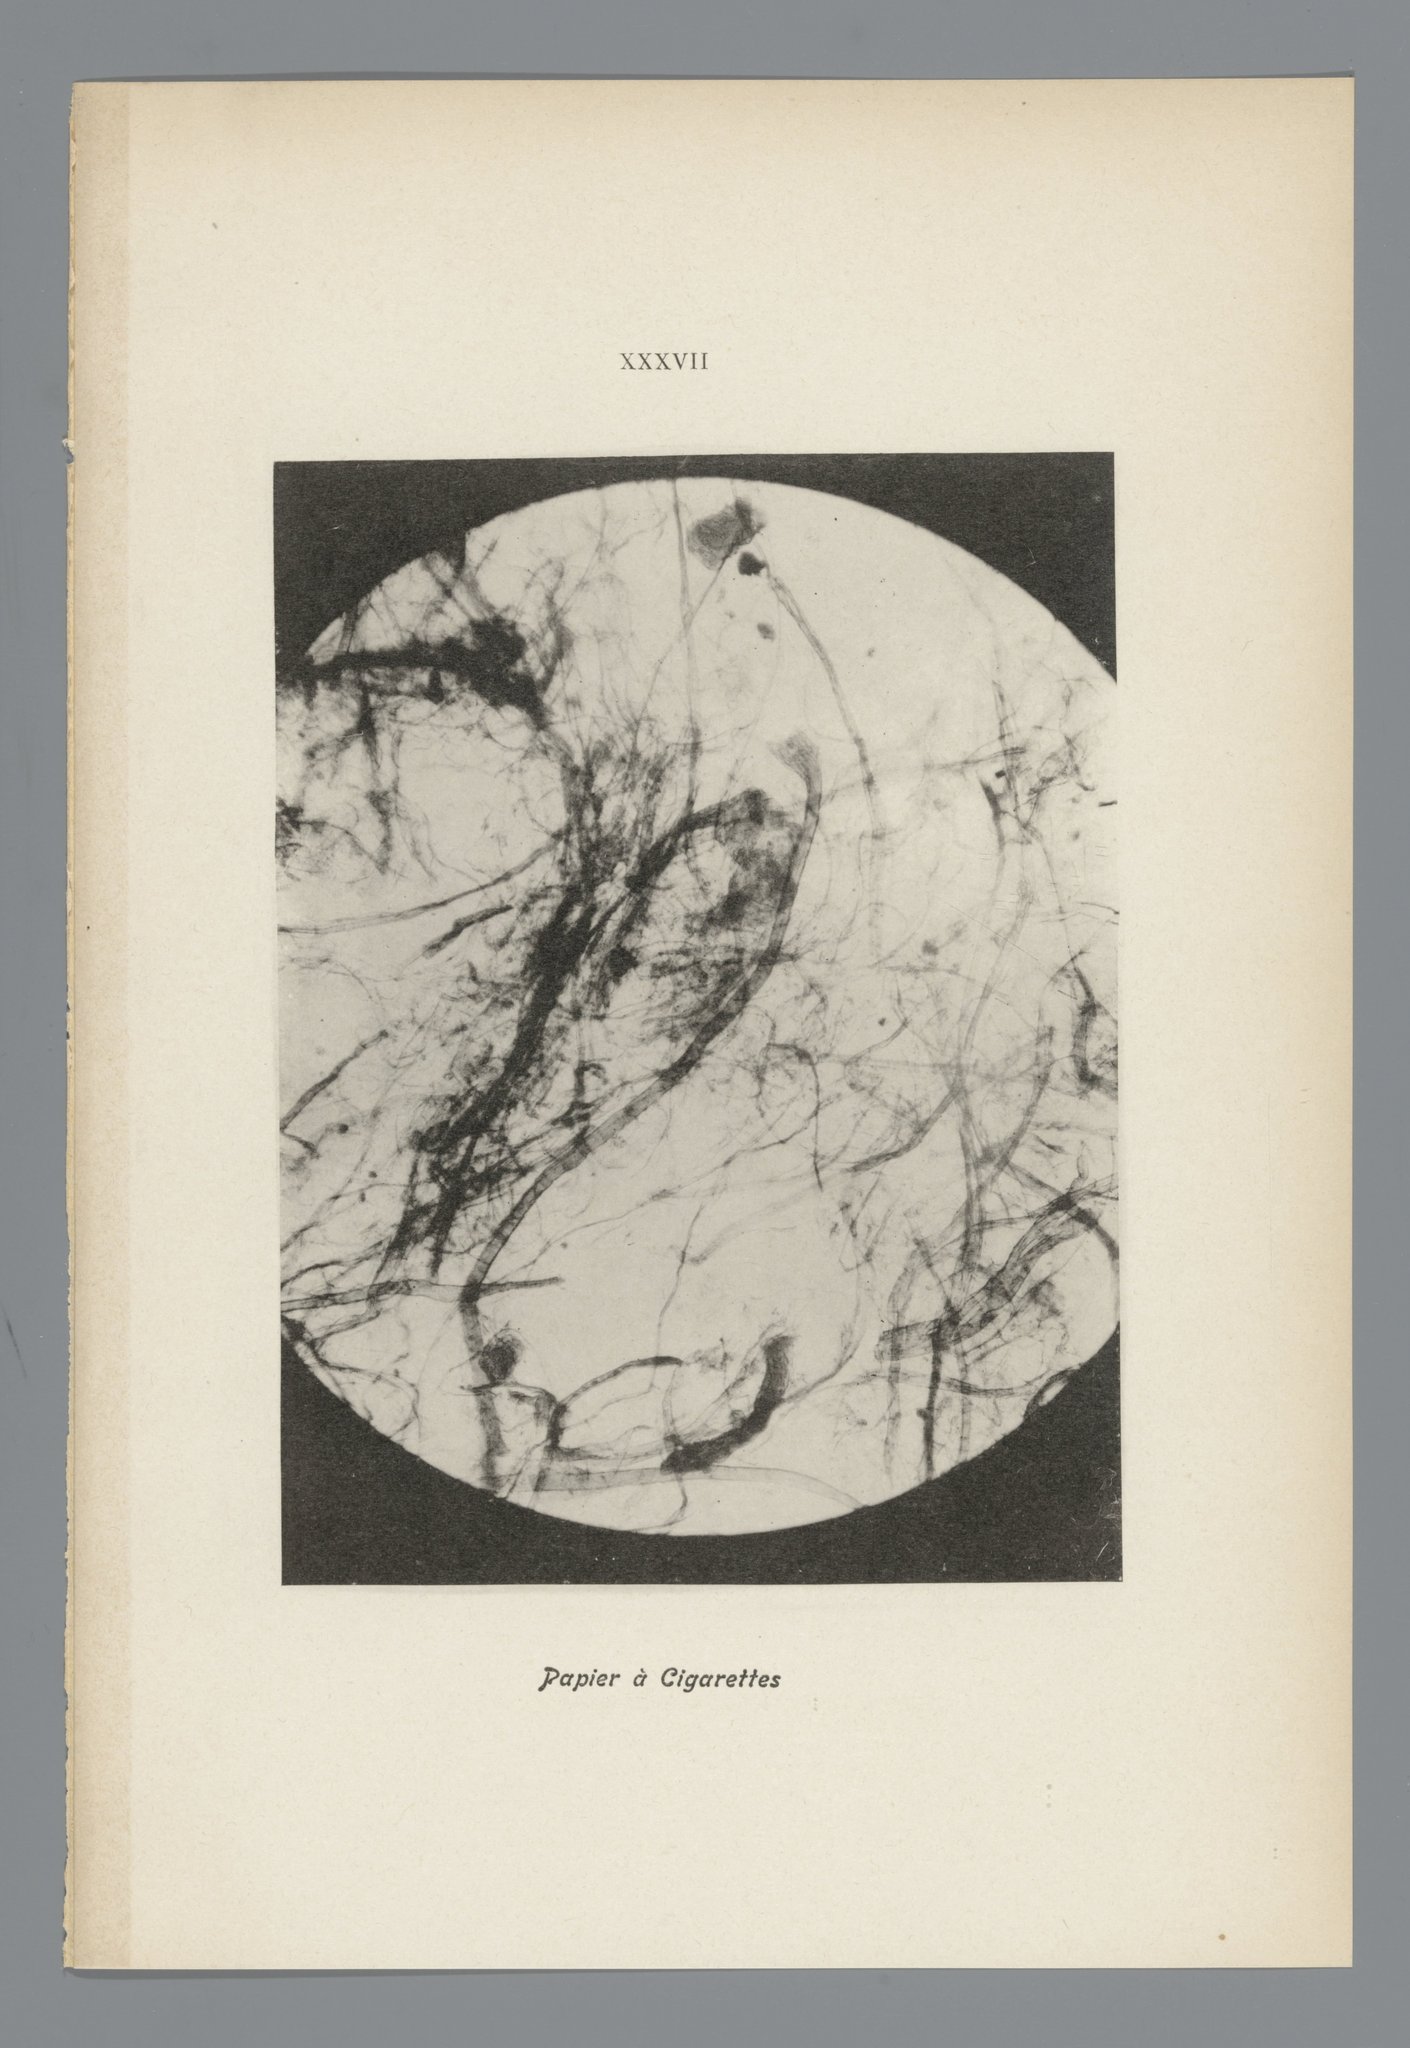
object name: photograph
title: Photomicrographs of Paper Fibres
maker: Anonymous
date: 1900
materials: ink, paper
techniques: photograph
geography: france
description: For science, photography was a useful tool for supplementing or refuting what could be observed with the human eye. The camera, after all, saw more than the eye, and the photographic plate had a better ‘memory’ than man. By combining a microscope and a camera, tiny objects could also be studied closely.